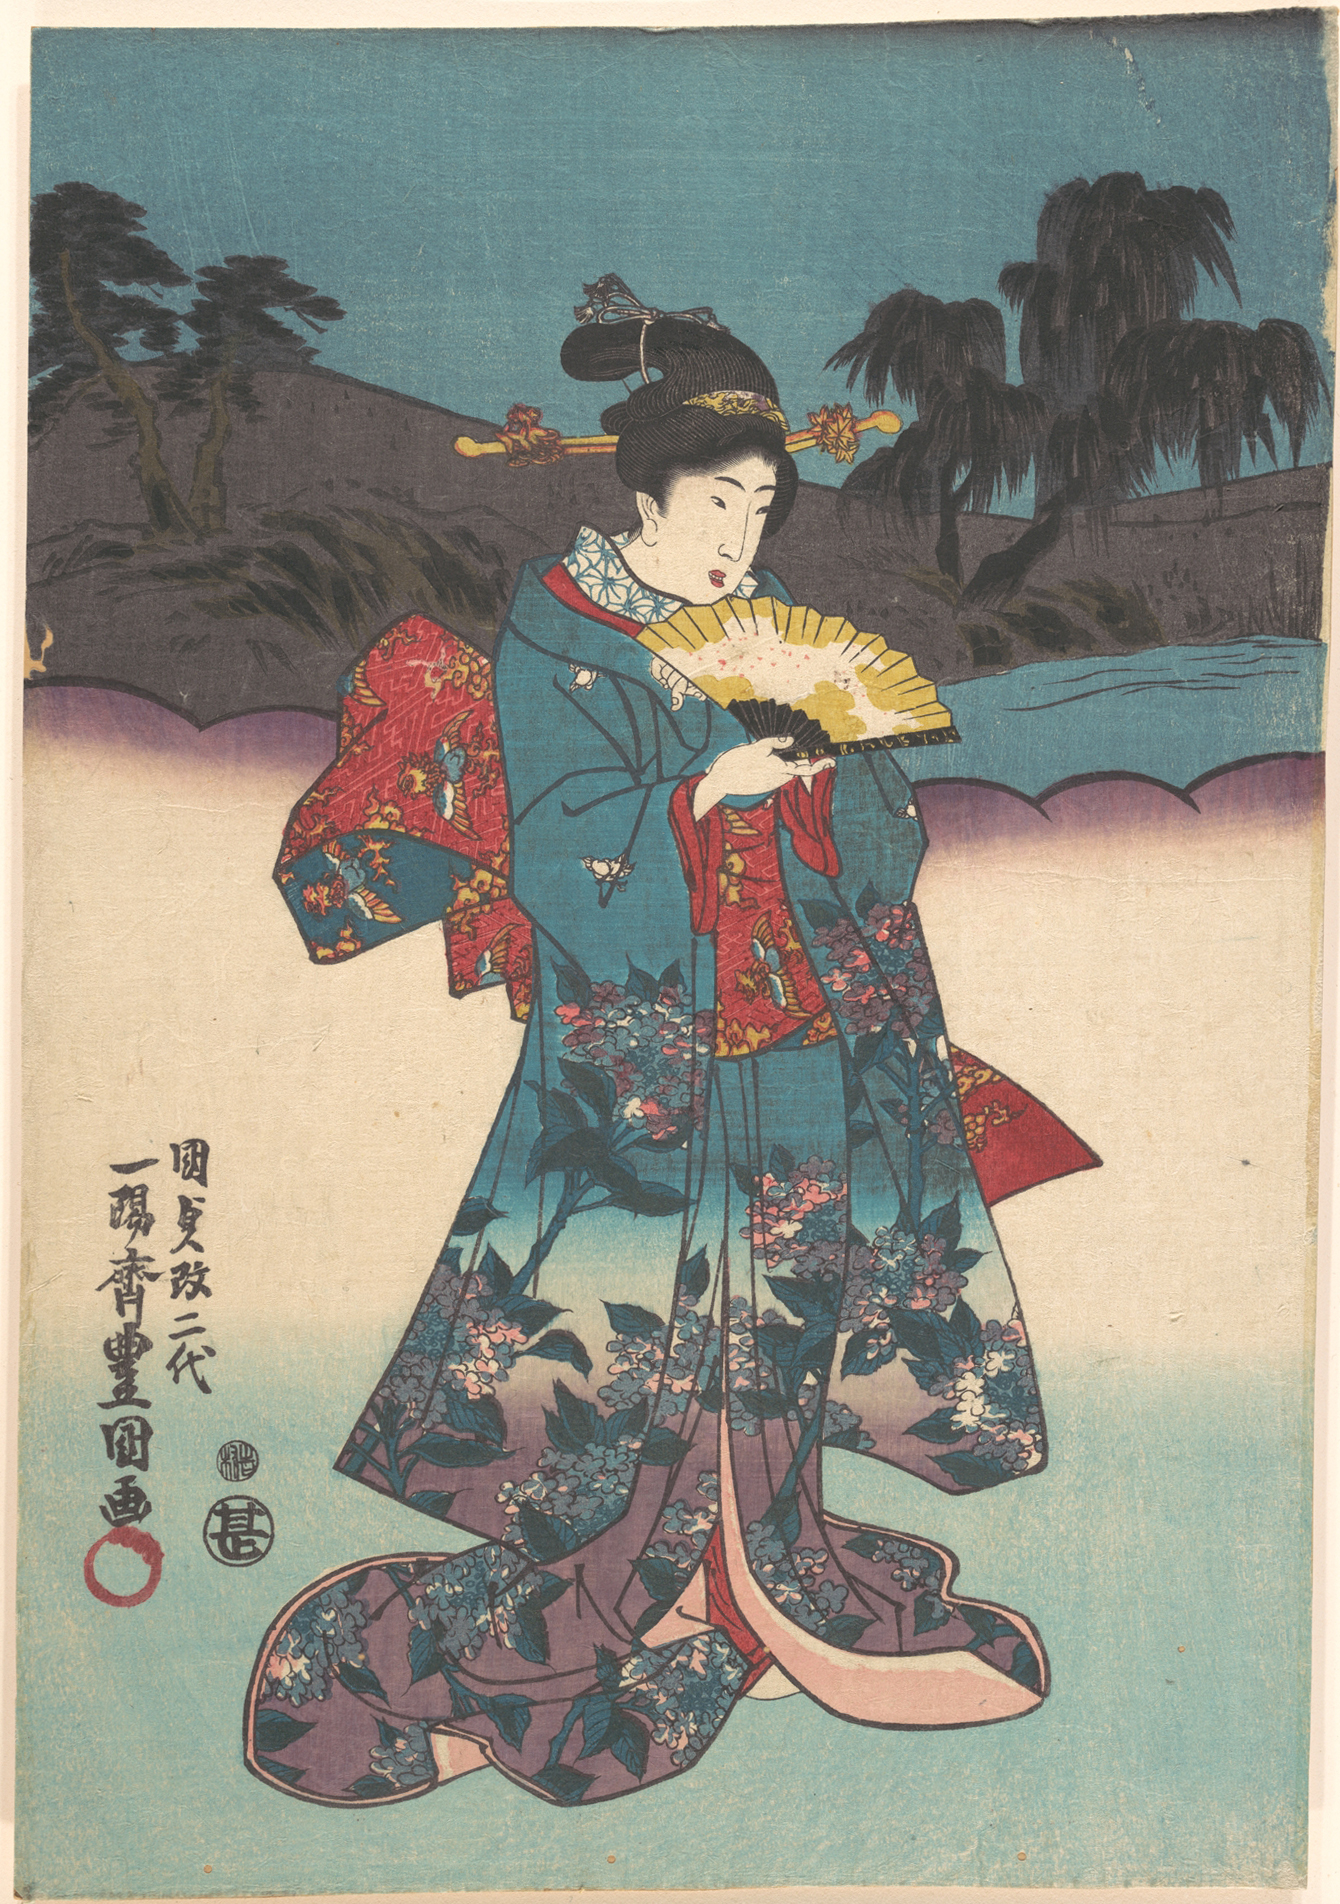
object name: print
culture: japanese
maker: utagawa kunisada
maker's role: artist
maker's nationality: japanese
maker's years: 1786-1864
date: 1786-1854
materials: ink, paper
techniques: woodblock print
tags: fans,women,hills,trees